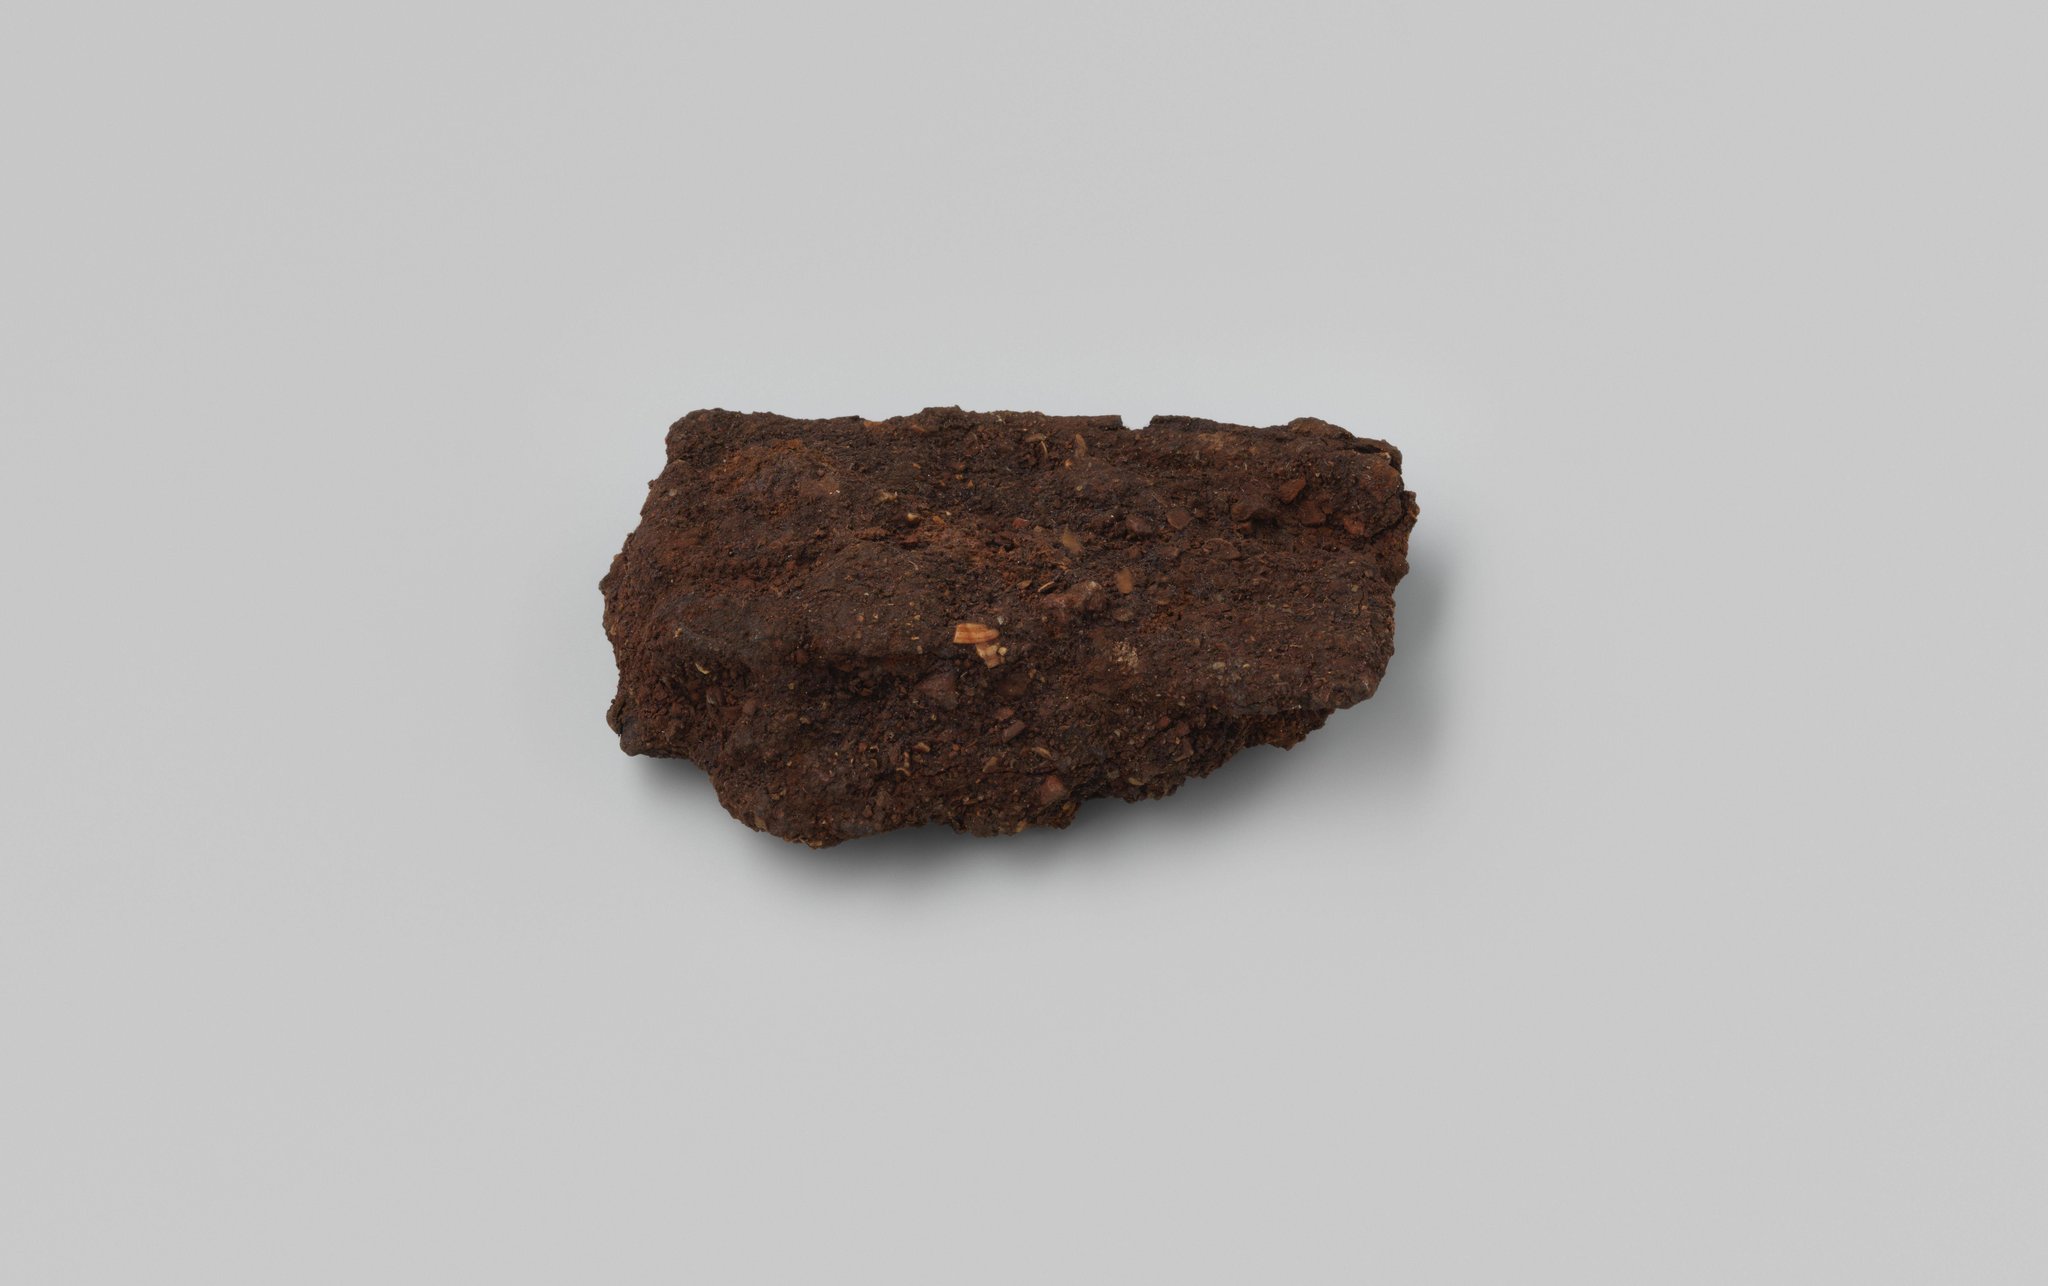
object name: part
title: Fragment of onderdeel uit het wrak van de Oost-Indiëvaarder Hollandia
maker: Anonymous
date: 1743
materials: iron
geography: netherlands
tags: verenigde oostindische compagnie, hollandia (schip), annet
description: Varied parts or fragments, bar(-shaped) fragments; fragm, heavily eroded, broken, encrusted, sim. 80H1807.